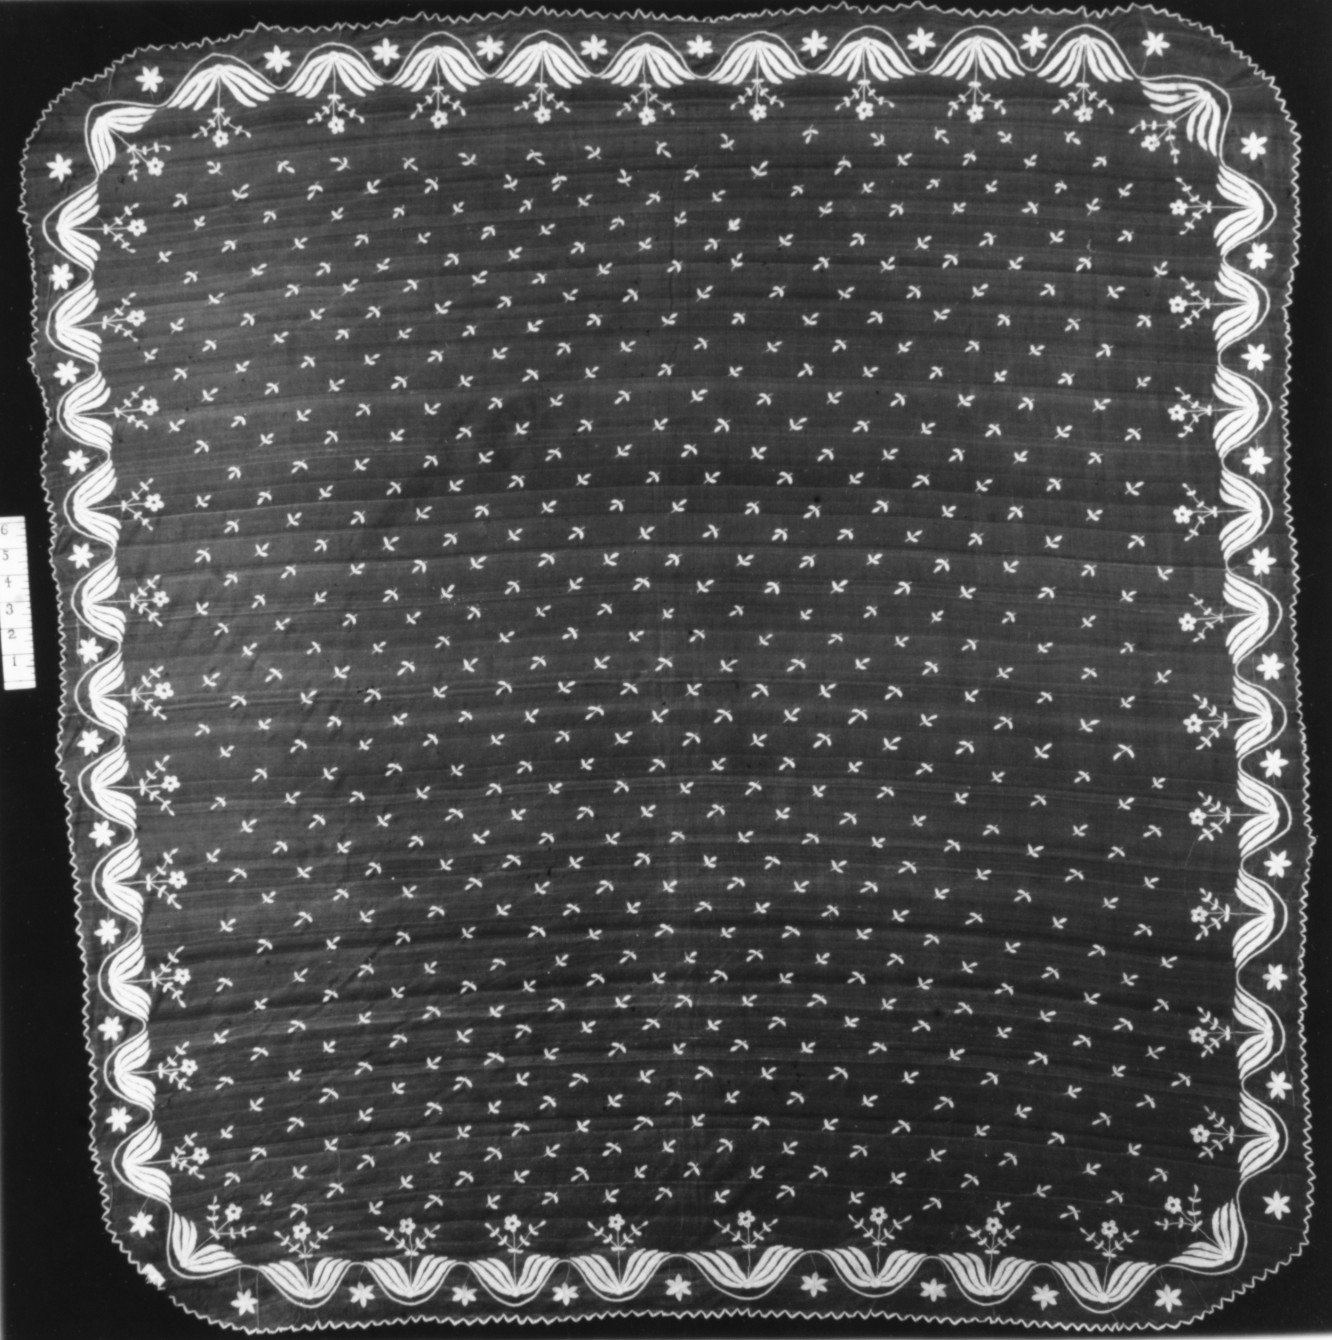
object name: square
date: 1815-1825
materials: silk